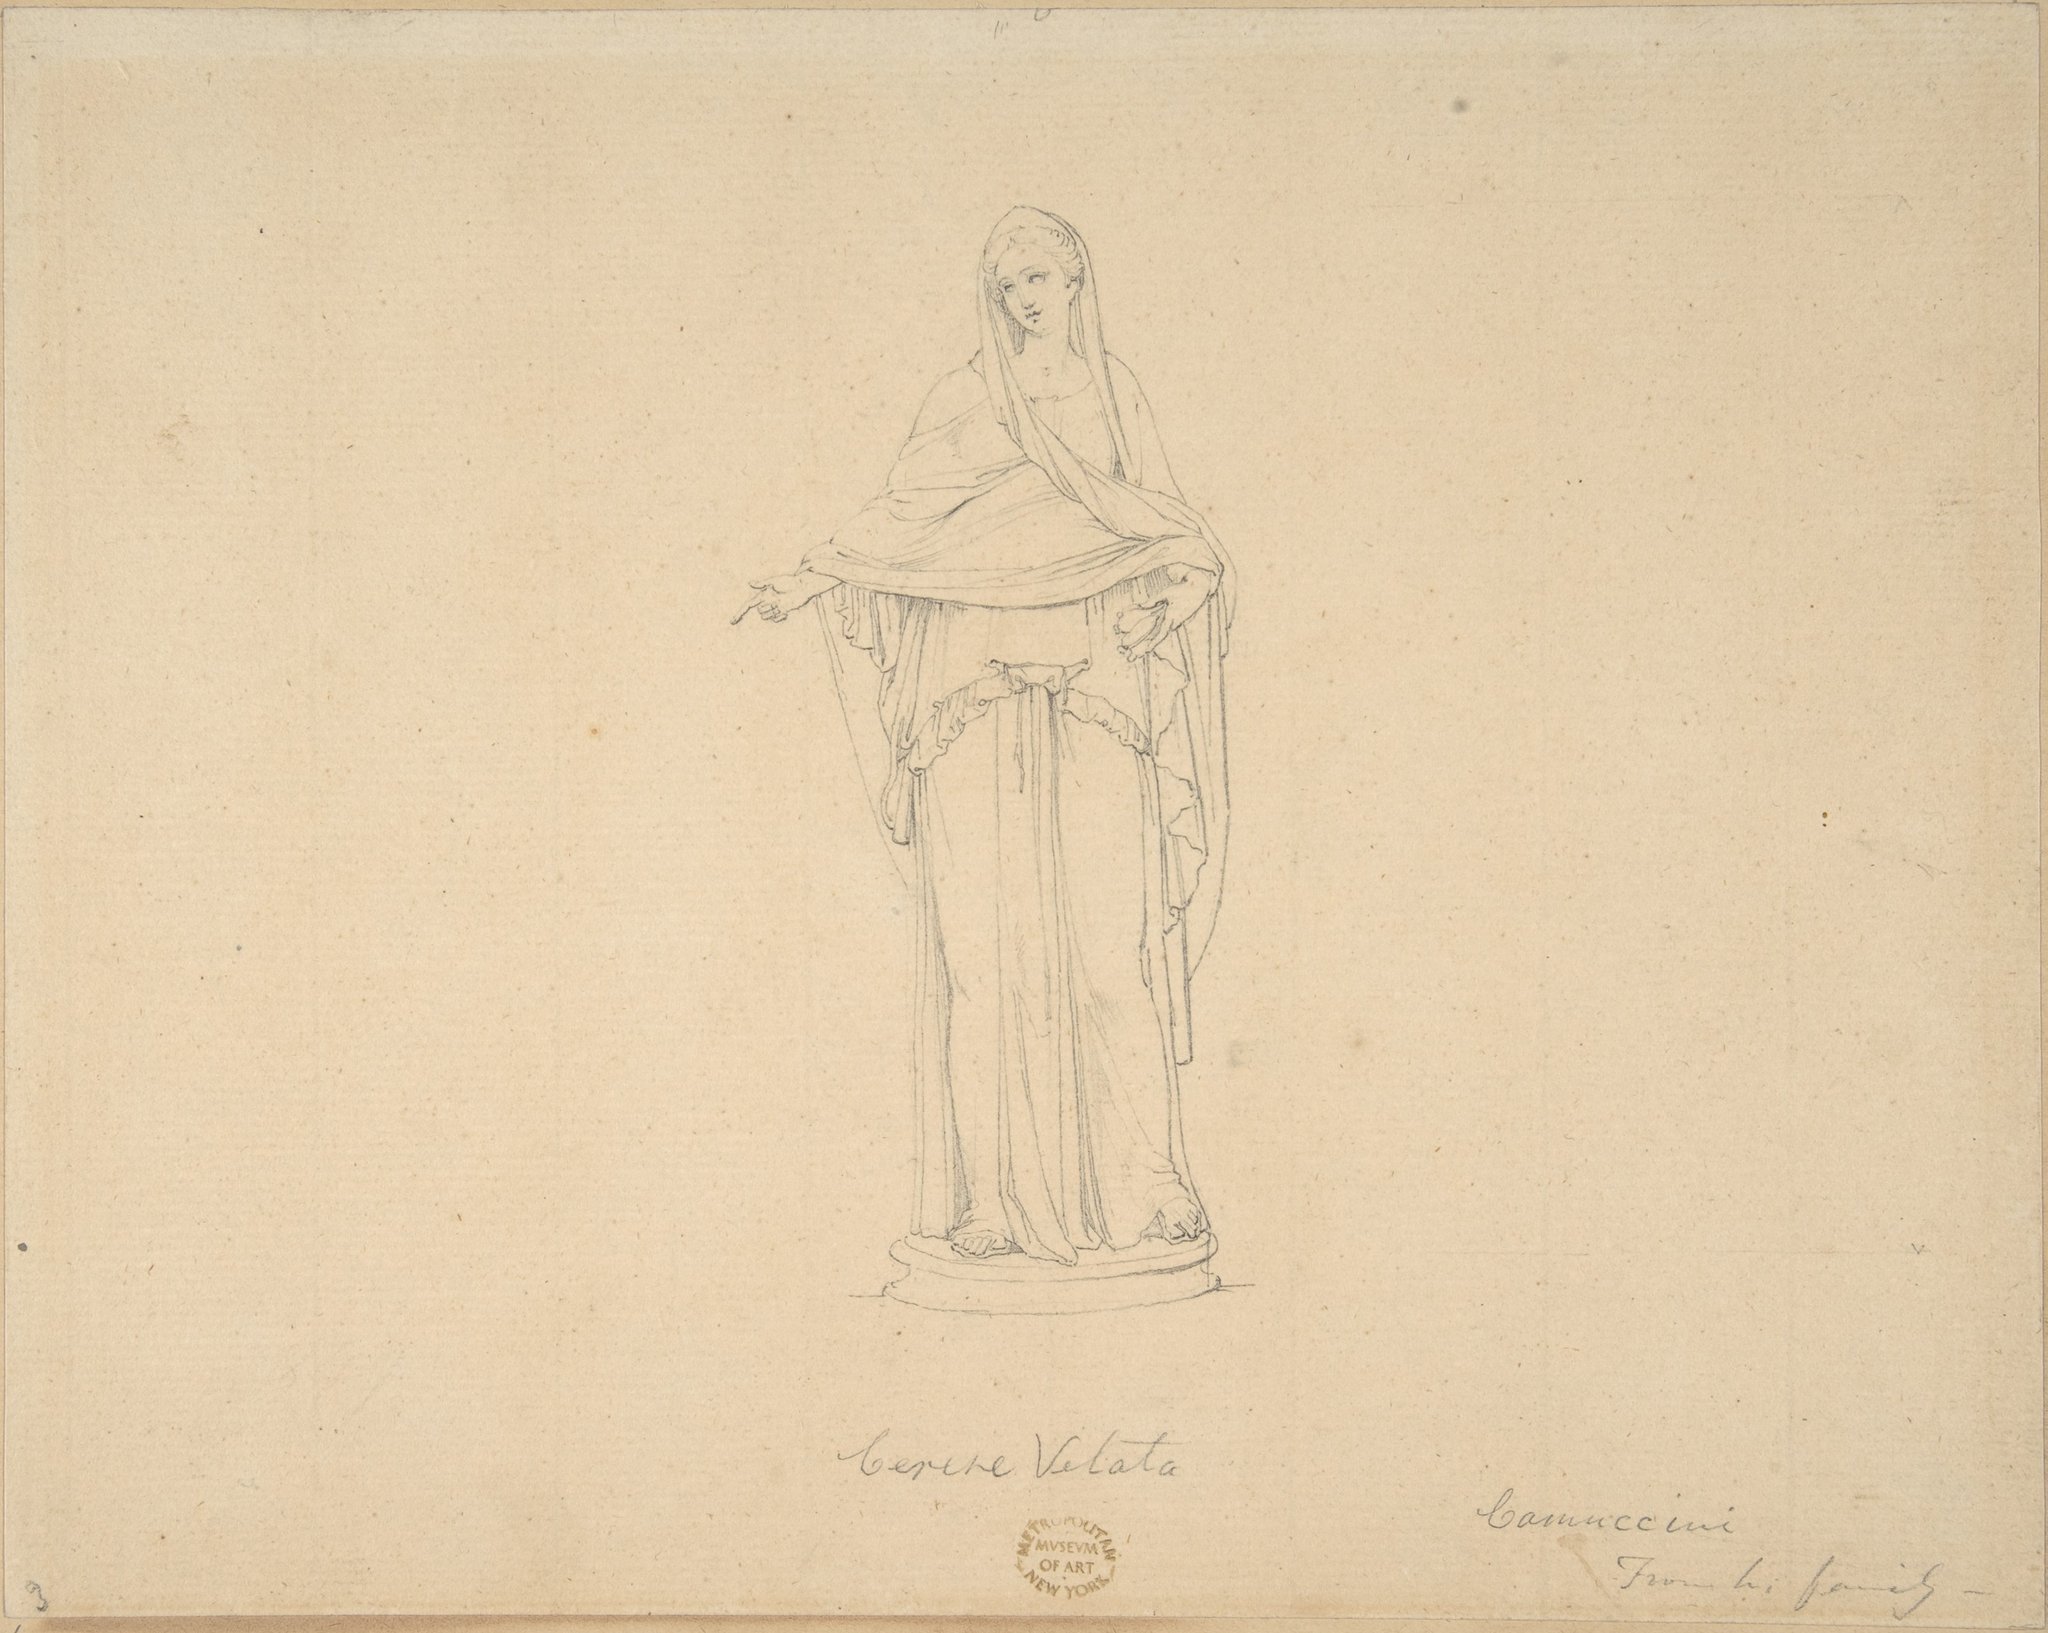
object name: drawing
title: Veiled Ceres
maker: vincenzo camuccini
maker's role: artist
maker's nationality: italian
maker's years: 1771-1844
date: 1795-1844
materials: graphite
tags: women